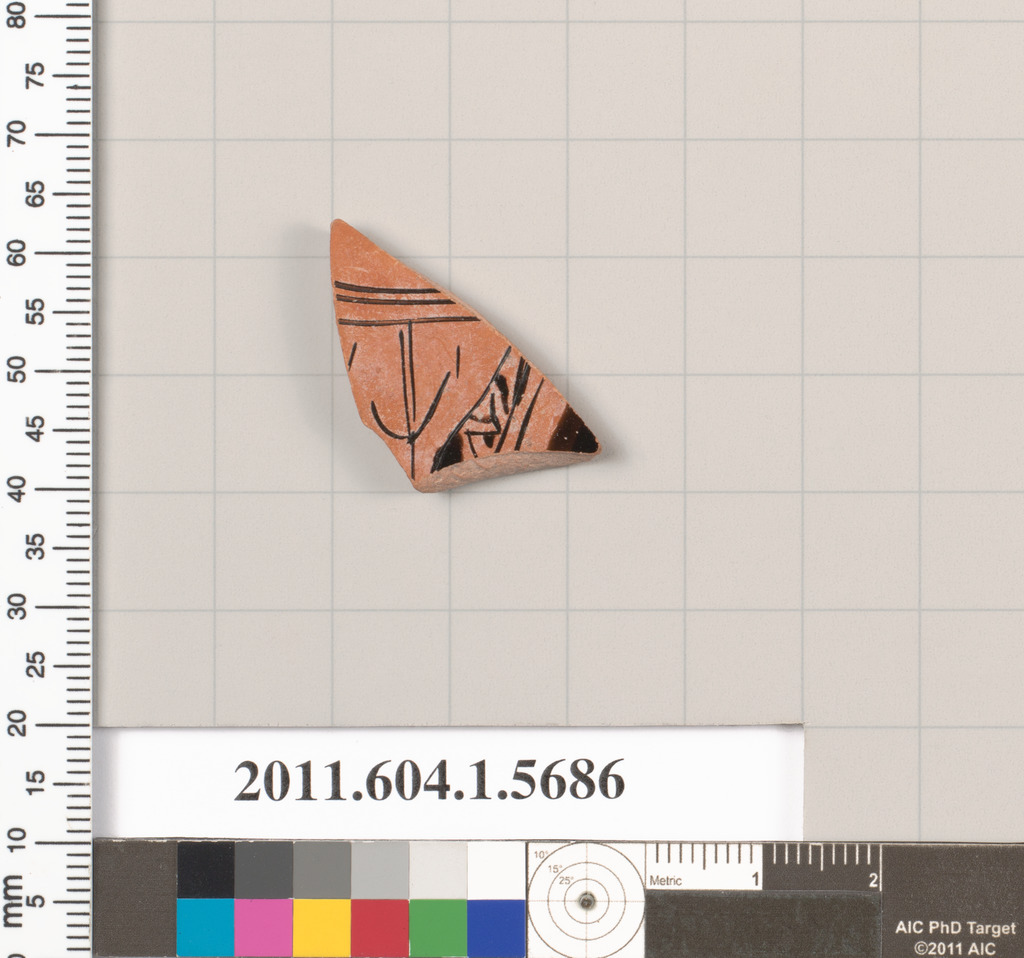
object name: kylix fragment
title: Terracotta fragment of a kylix (drinking cup)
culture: greek, attic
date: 500-480 BCE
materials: terracotta